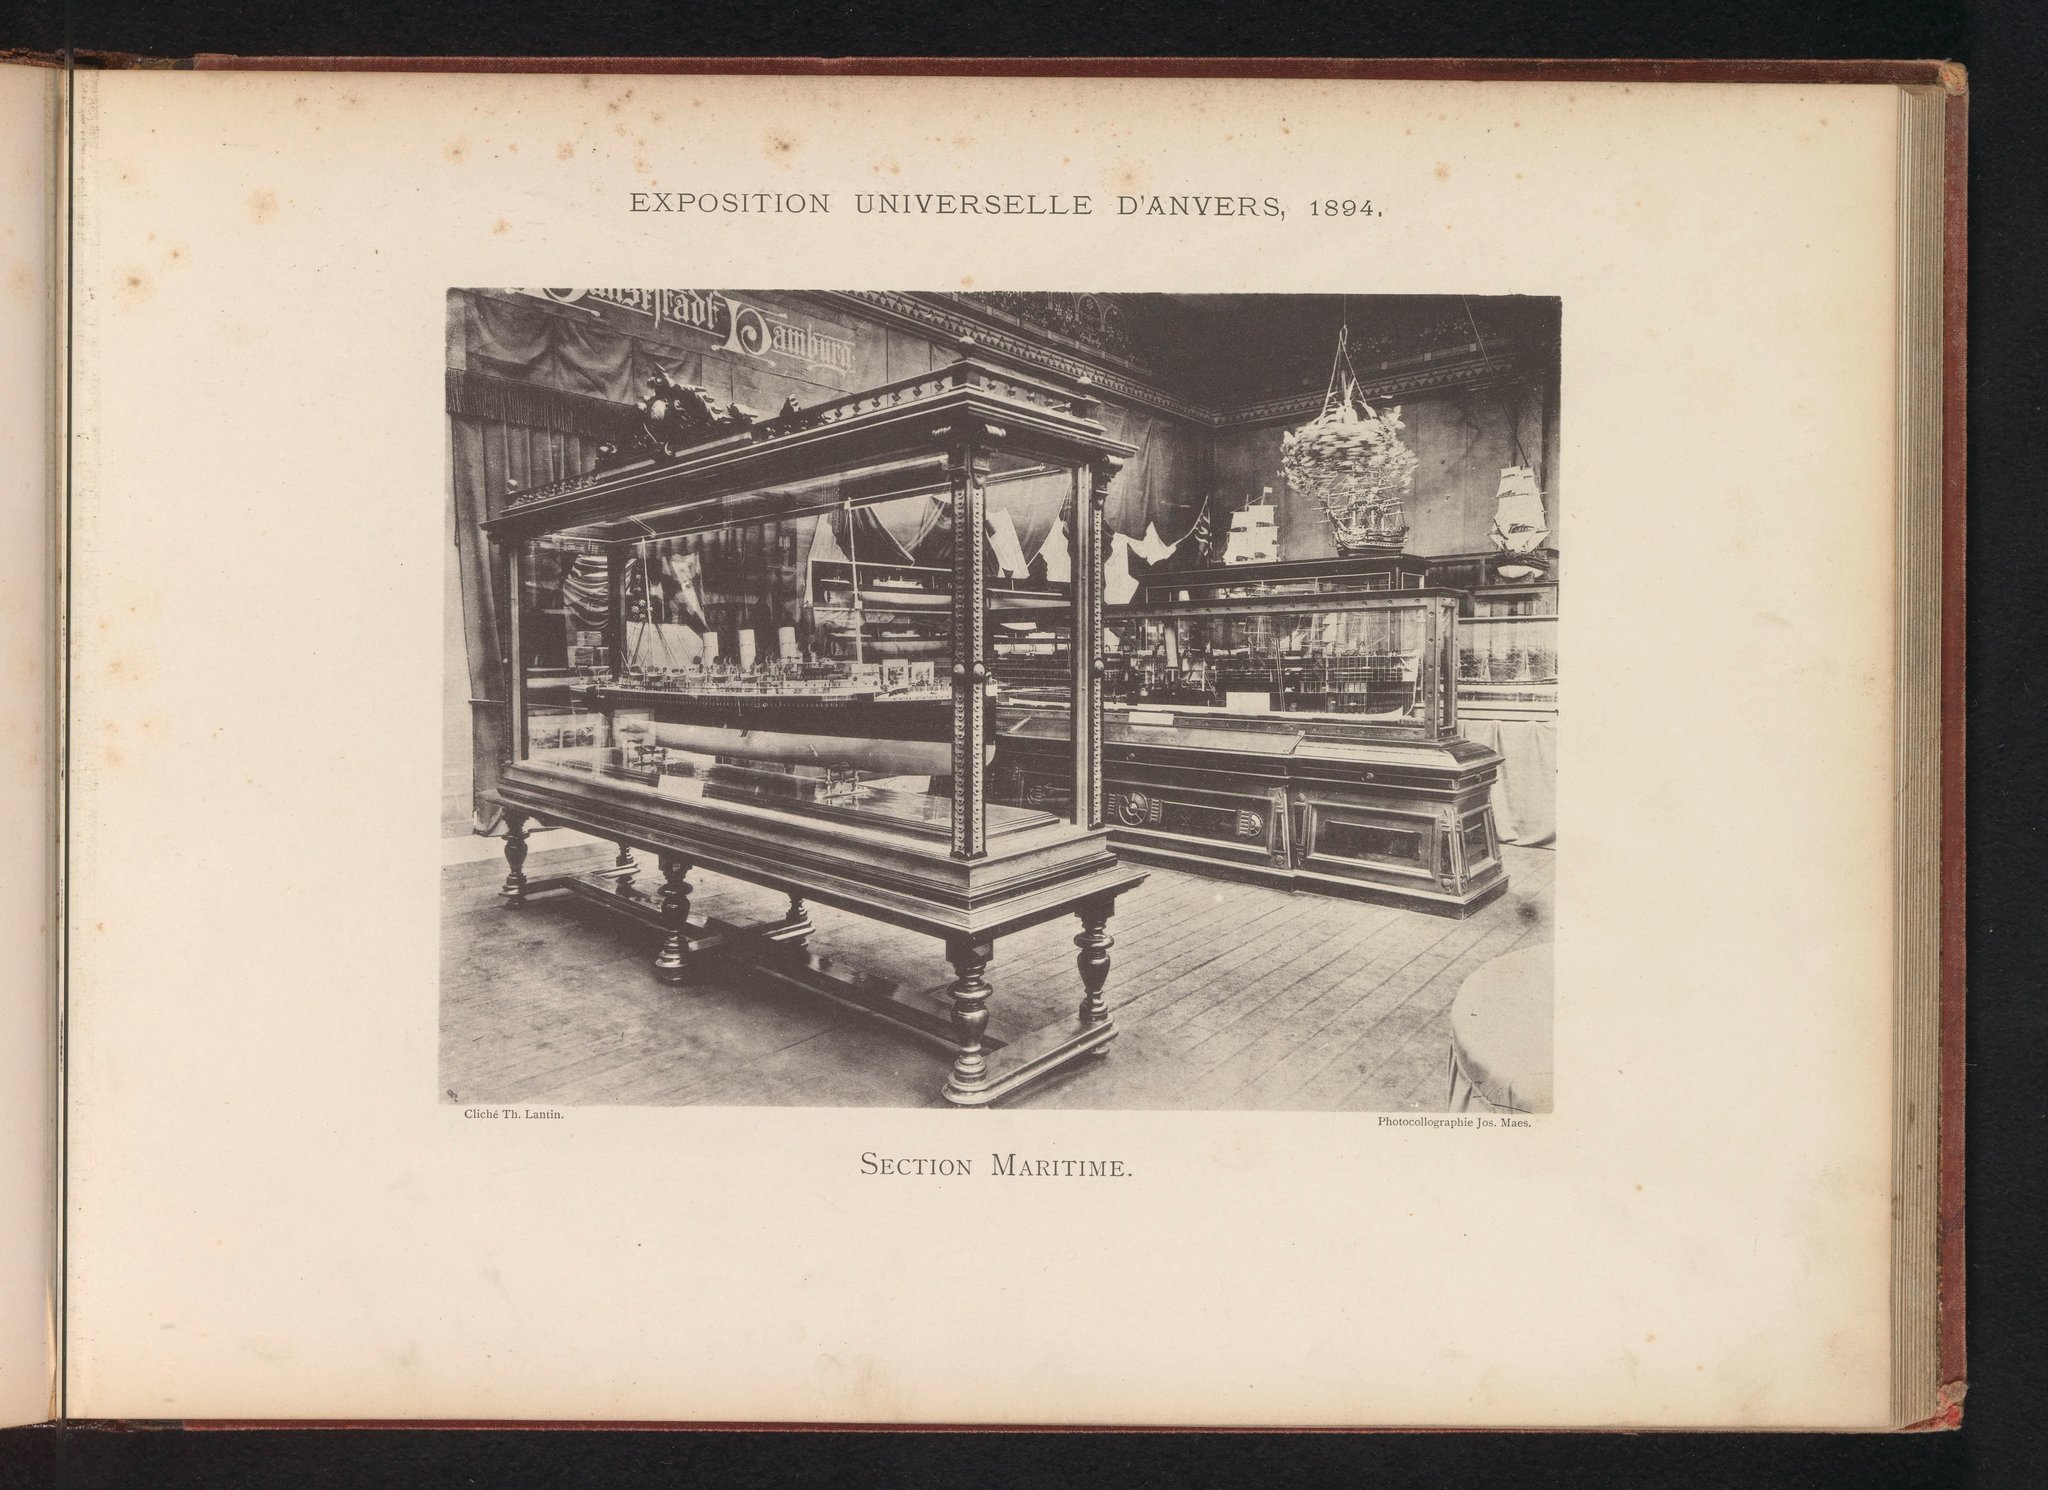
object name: page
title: Section Maritime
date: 1894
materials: paper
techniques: photograph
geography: antwerp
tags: world fair, world exhibition, collection, exhibition, show, ship-model